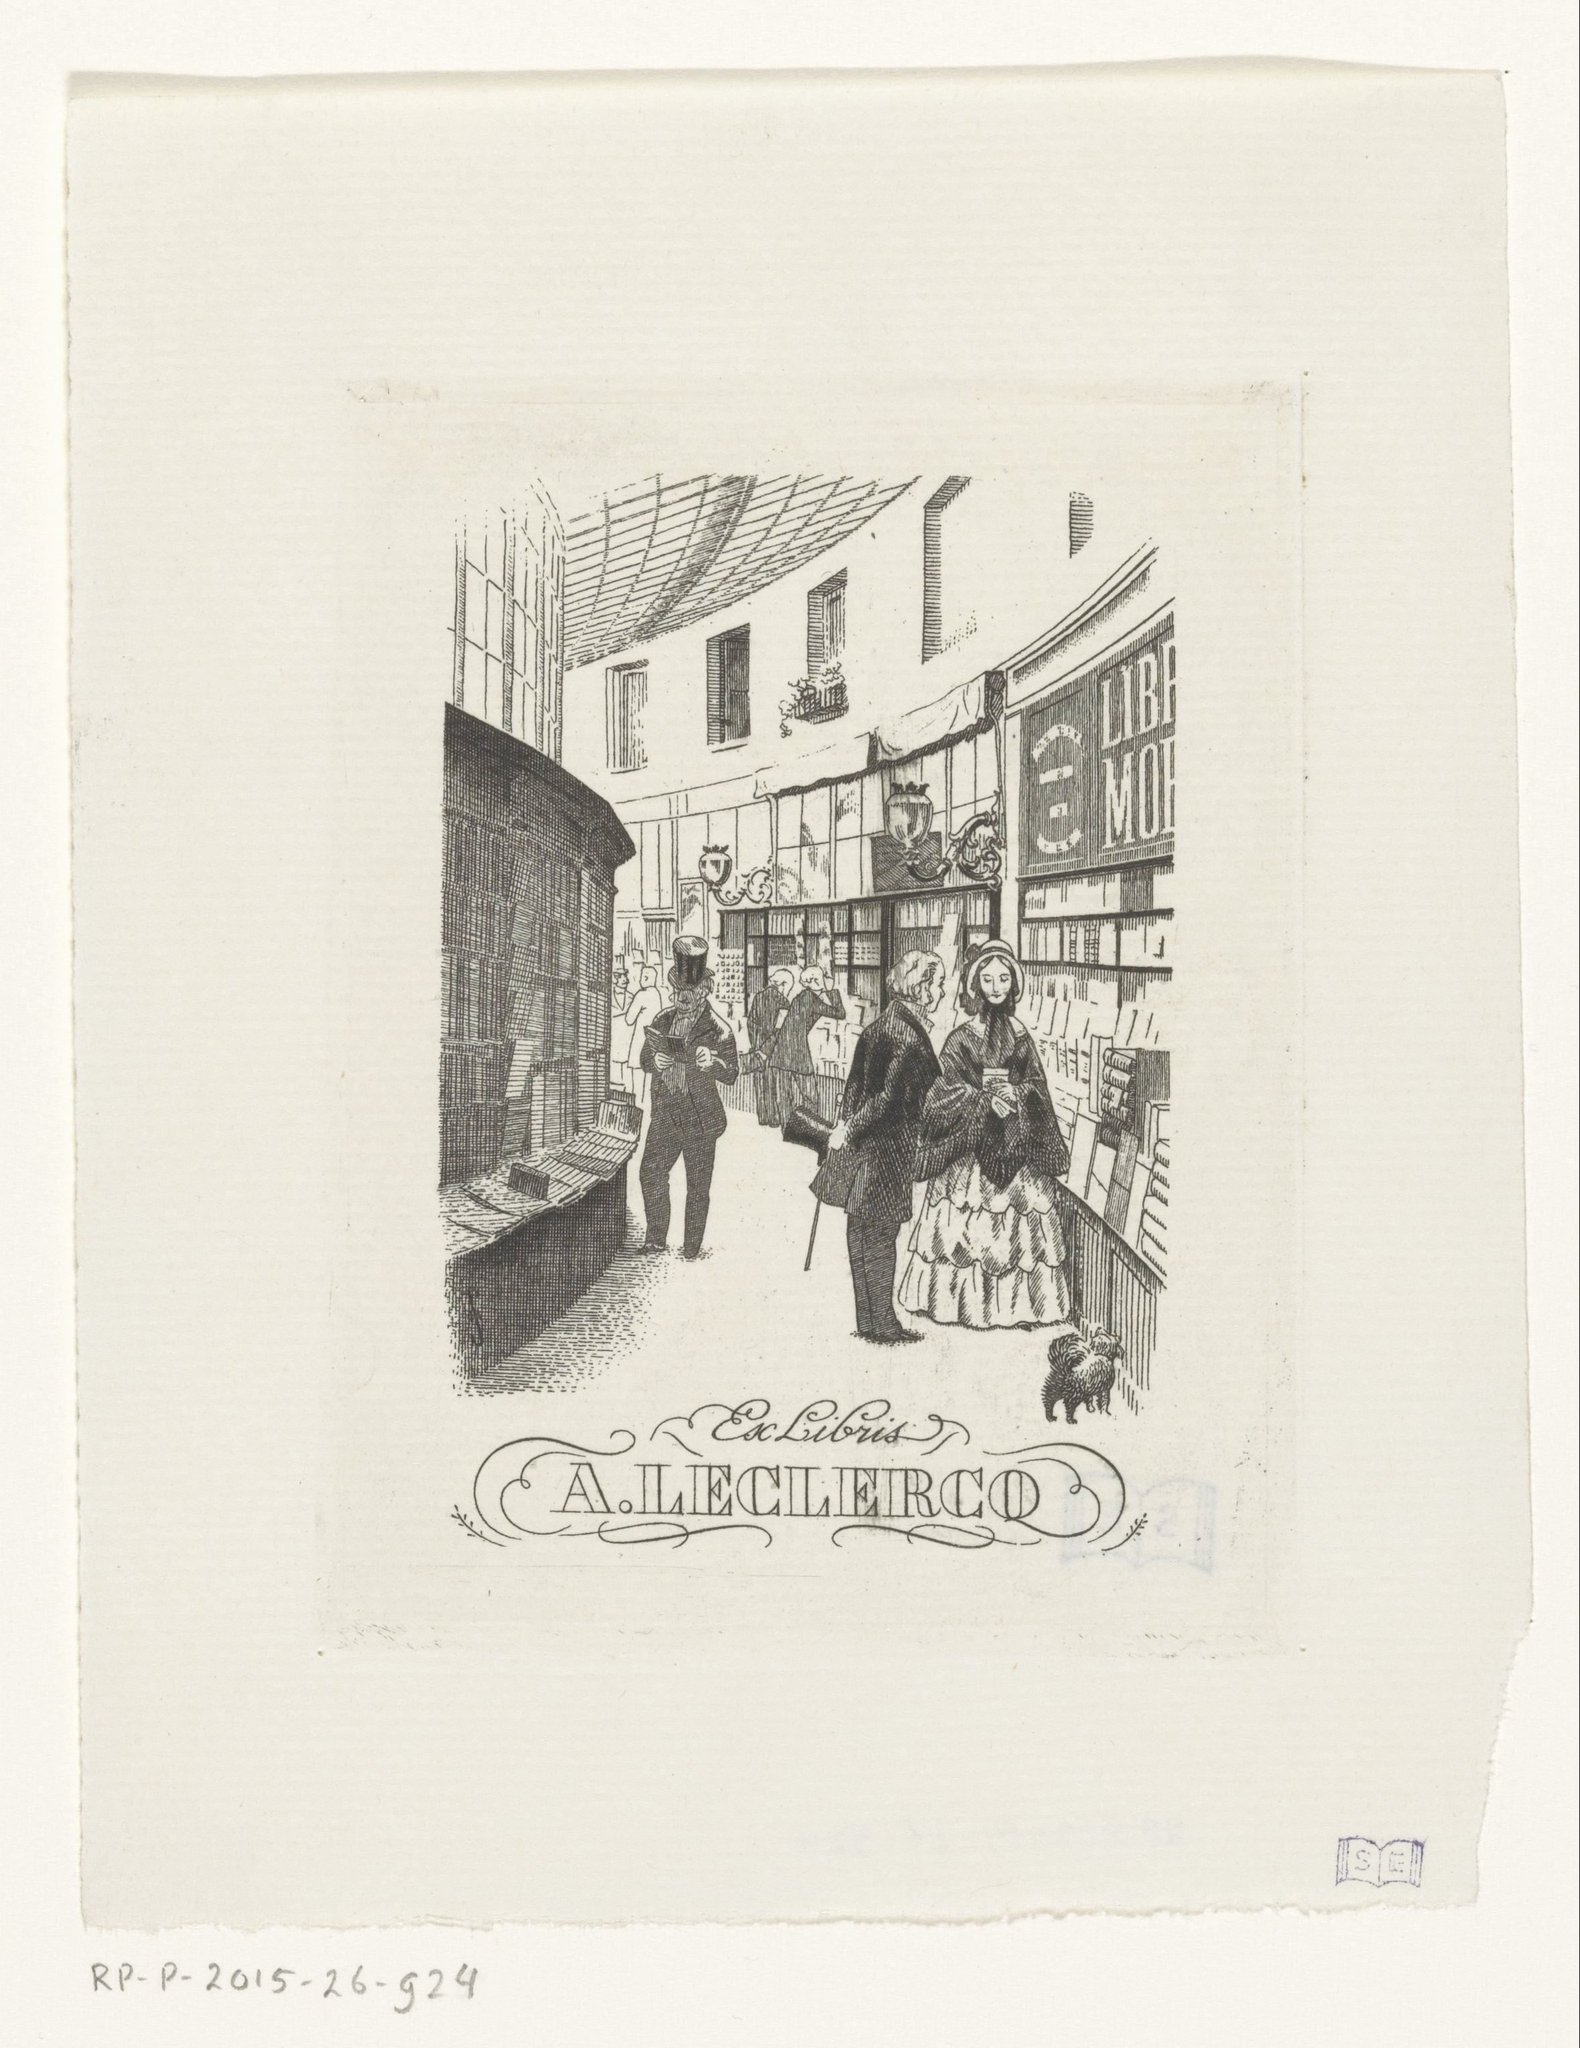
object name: print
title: Ex libris A. Leclercq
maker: Anonymous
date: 1925-1975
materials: paper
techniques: etching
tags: book-shop, bookseller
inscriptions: collector's mark: Lugt 4779, monogram: ‘MS [?]’, collector's mark: Lugt 4780, collector's mark: Lugt 2228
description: De boekhandel van Alex Leclerq vormde een voortzetting van de winkel die Jean-Baptiste Moens rond 1848 was begonnen in de Galerie Bortier te Brussel.